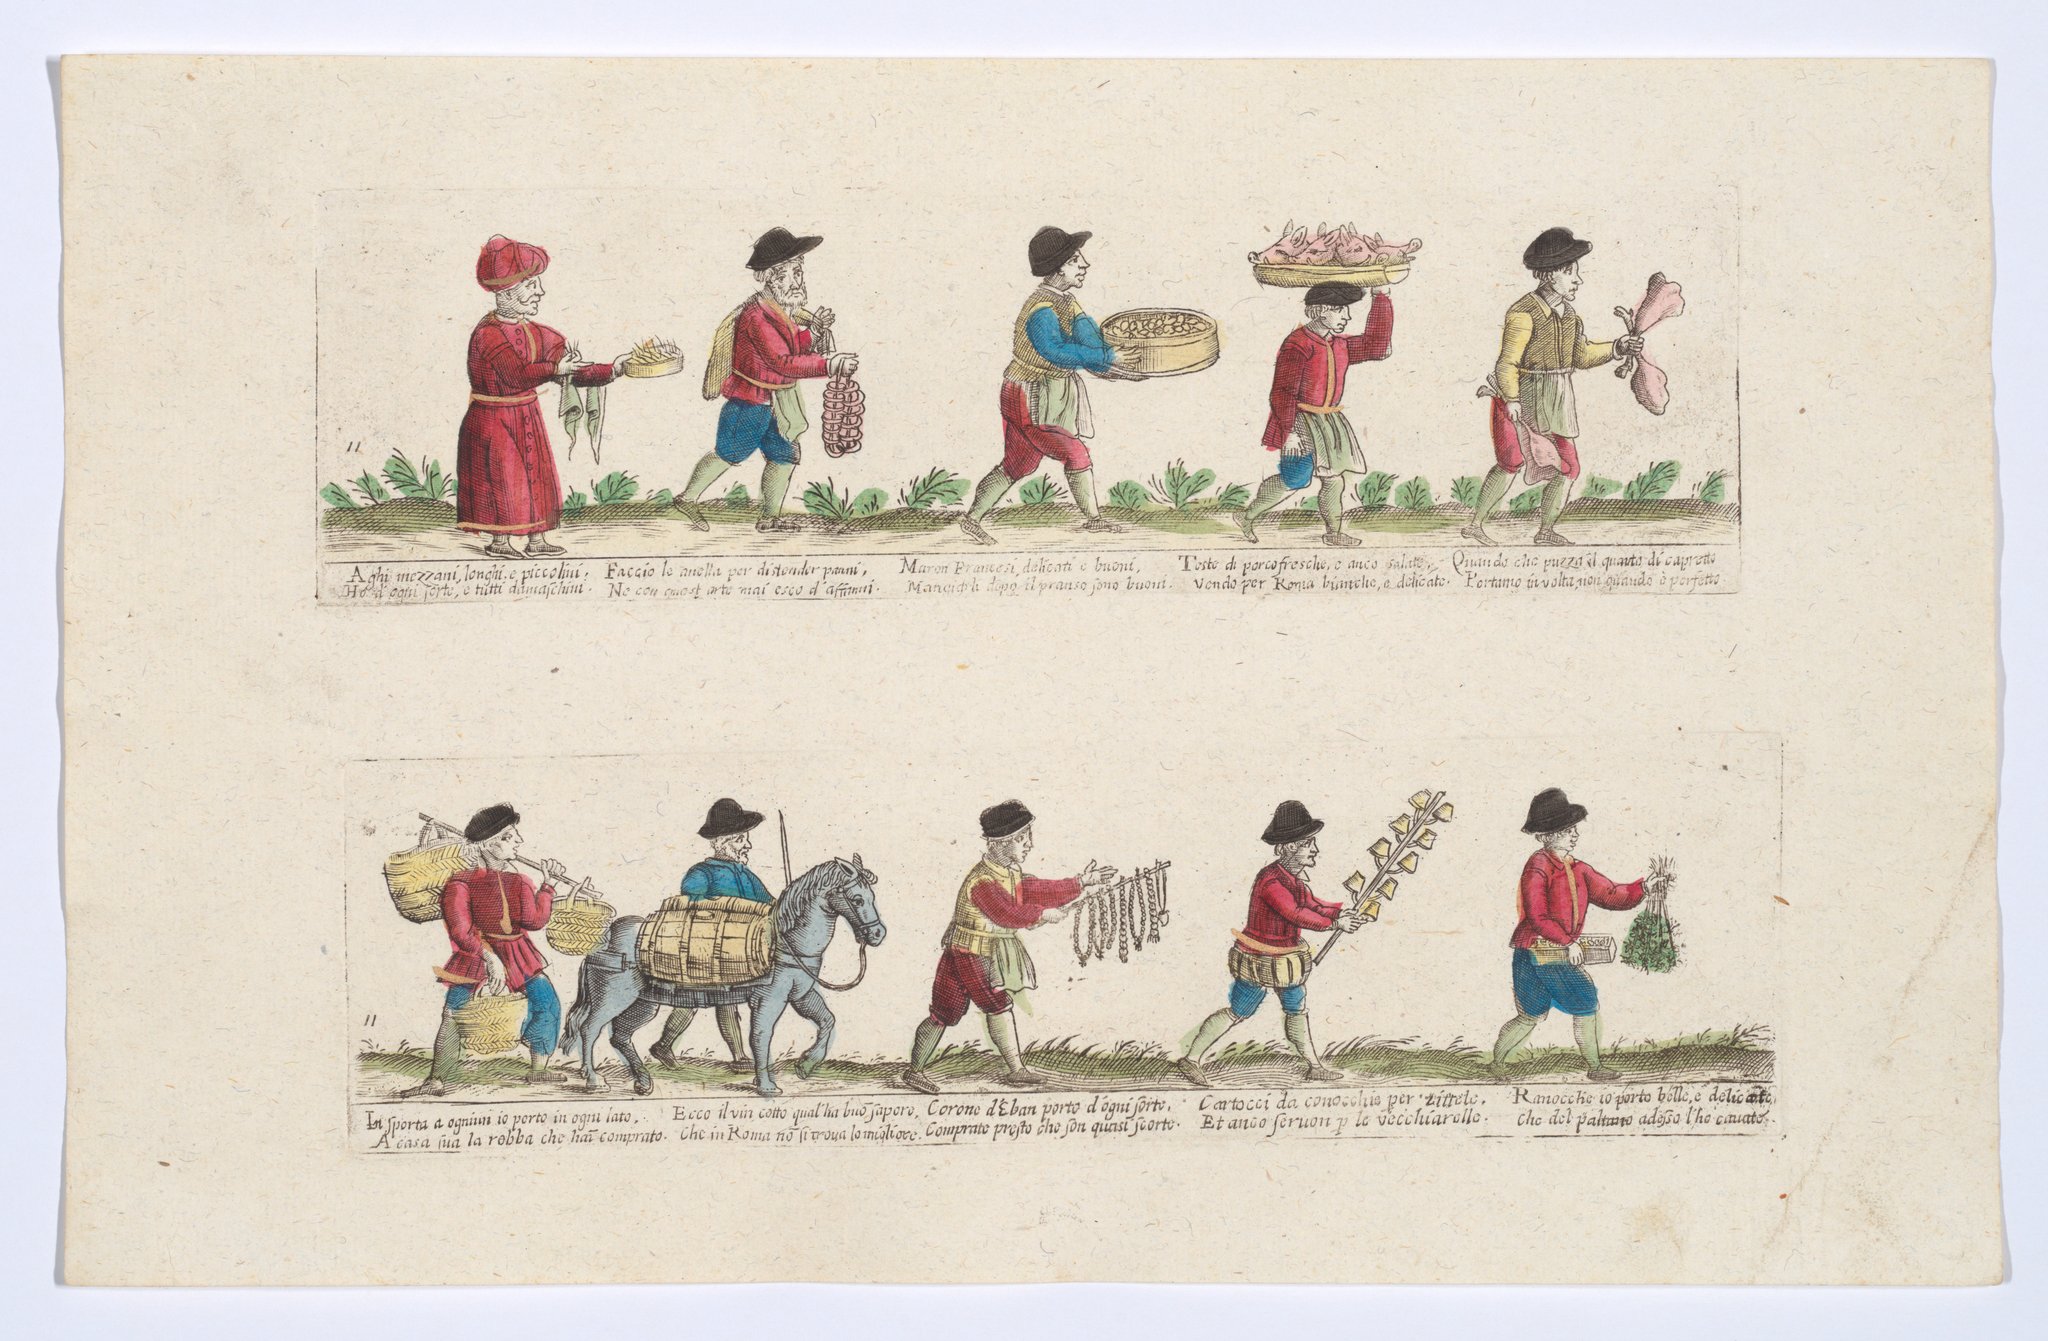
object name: print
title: Plate 11 depicting the trades of Rome, here including vendors of pigs heads, milk, wine etc, from the 'Descrición de las artes que se llaman para los calles de la ciudad de Roma'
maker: remondini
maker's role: publisher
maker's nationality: italian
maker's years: 1650-1860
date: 1770-1800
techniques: engraving, hand coloring